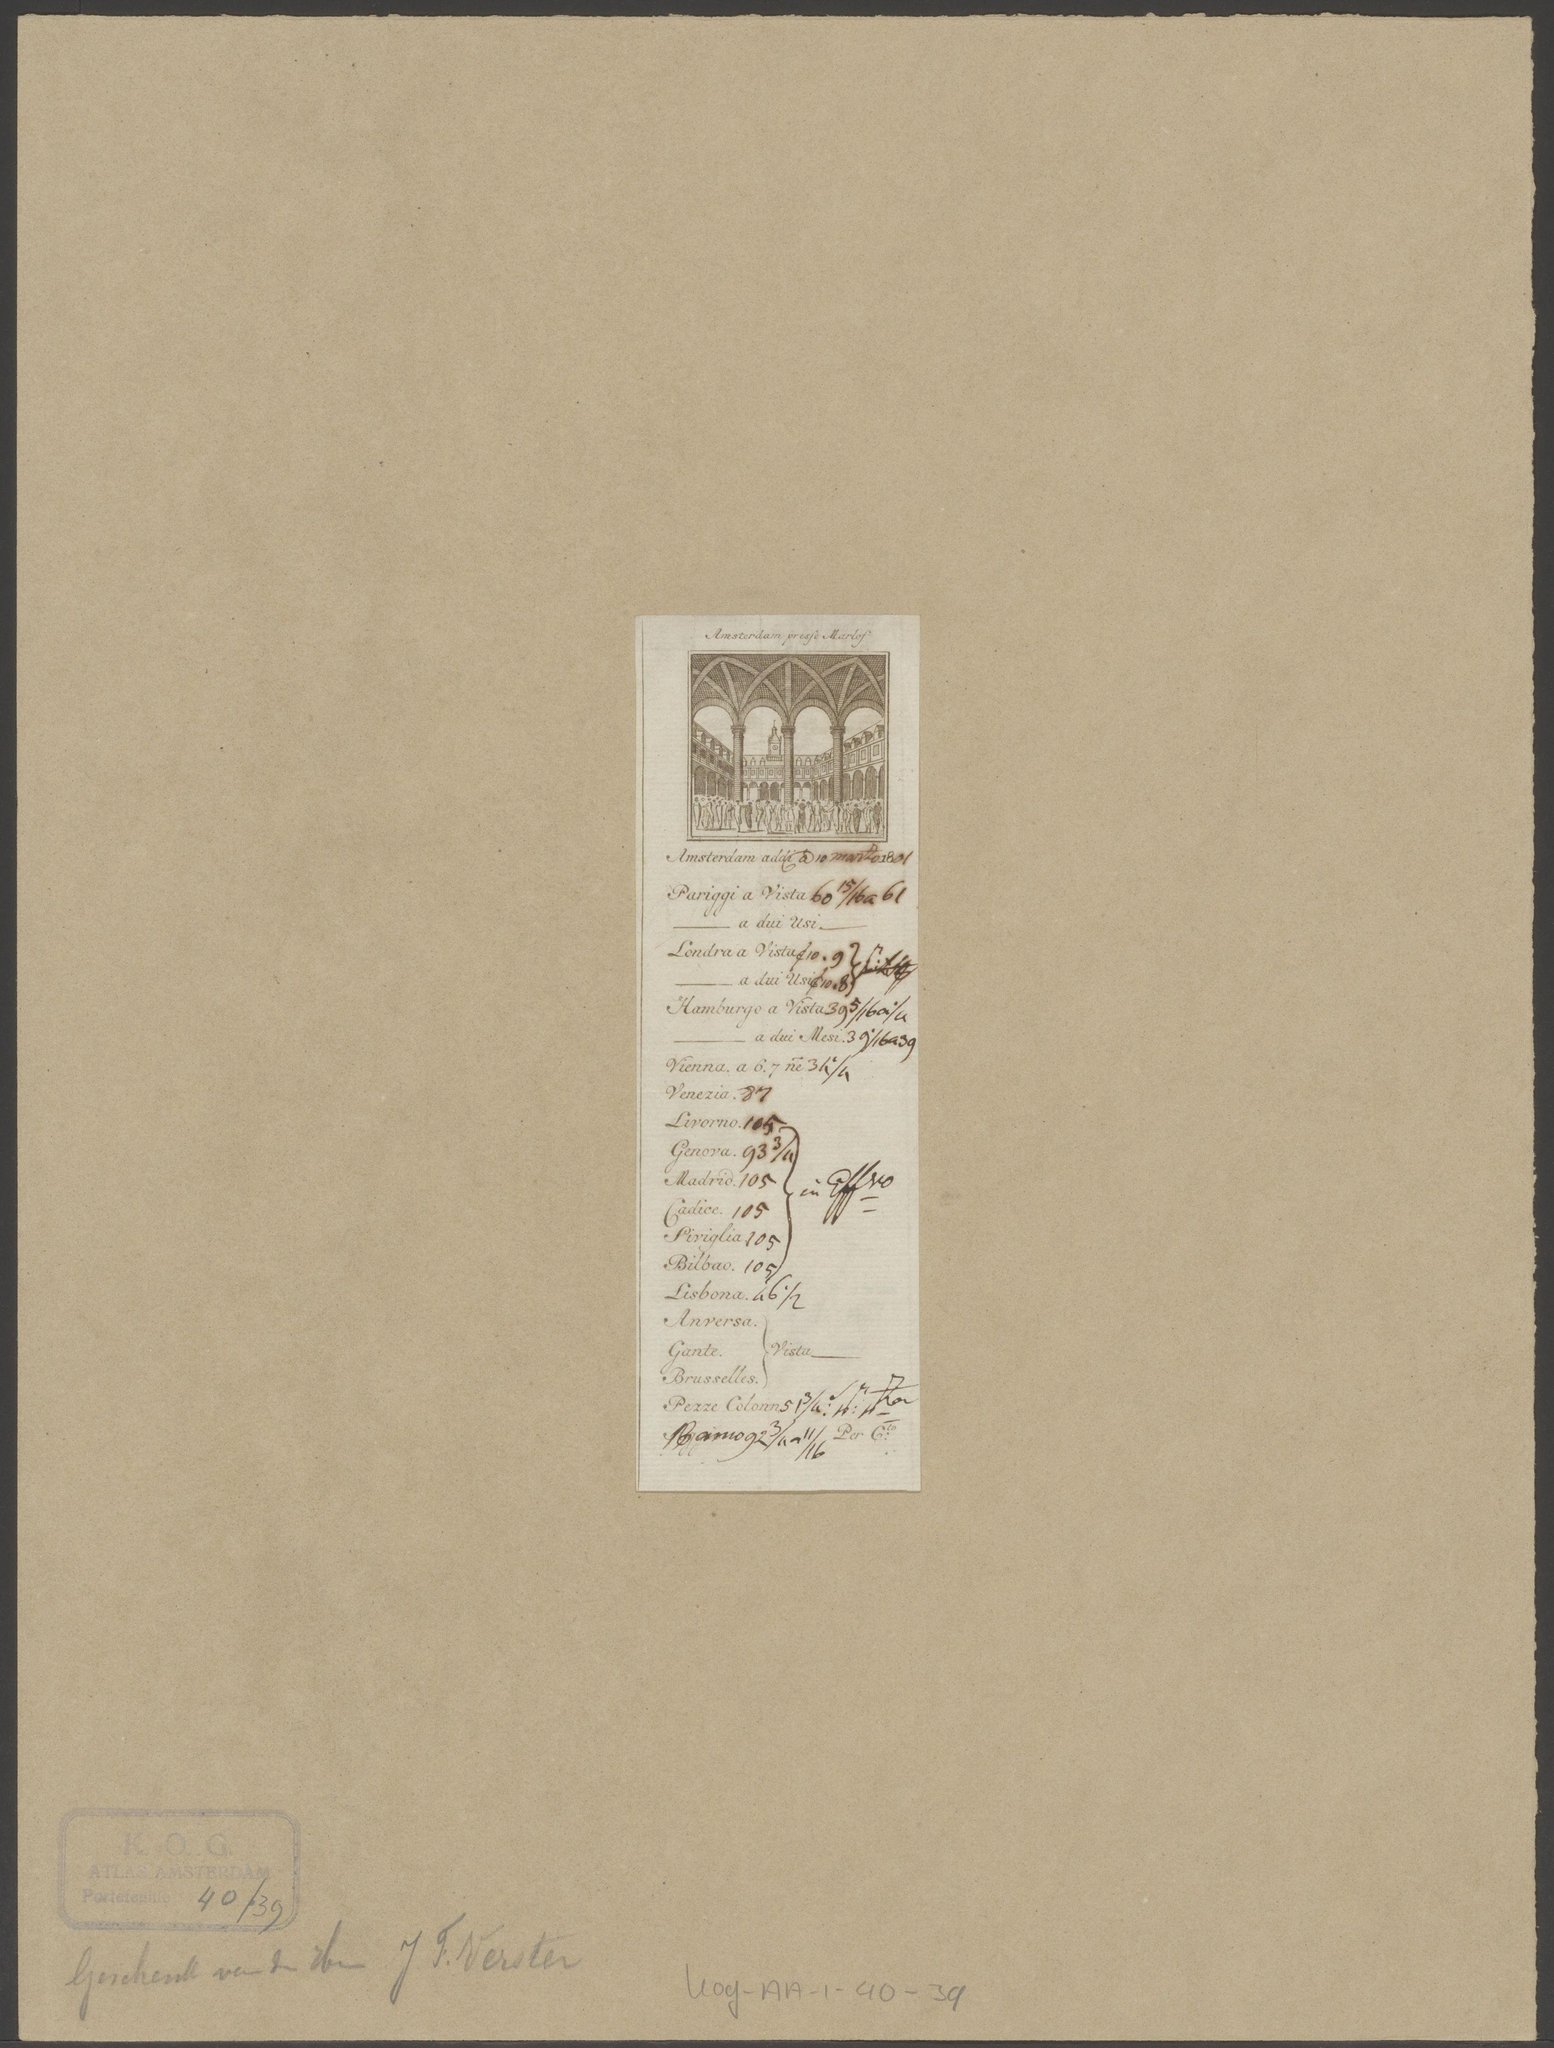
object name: frame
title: Amsterdam presso Marlof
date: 1801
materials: paper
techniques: engraving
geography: amsterdam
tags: stock exchange, stock-market, courtyard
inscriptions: collector's mark: Lugt 1641b, name: ‘Marlof’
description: Onderwerpsrubriek binnen de Atlas Amsterdam: Handel en Zeevaart: Beurs op het Rokin.